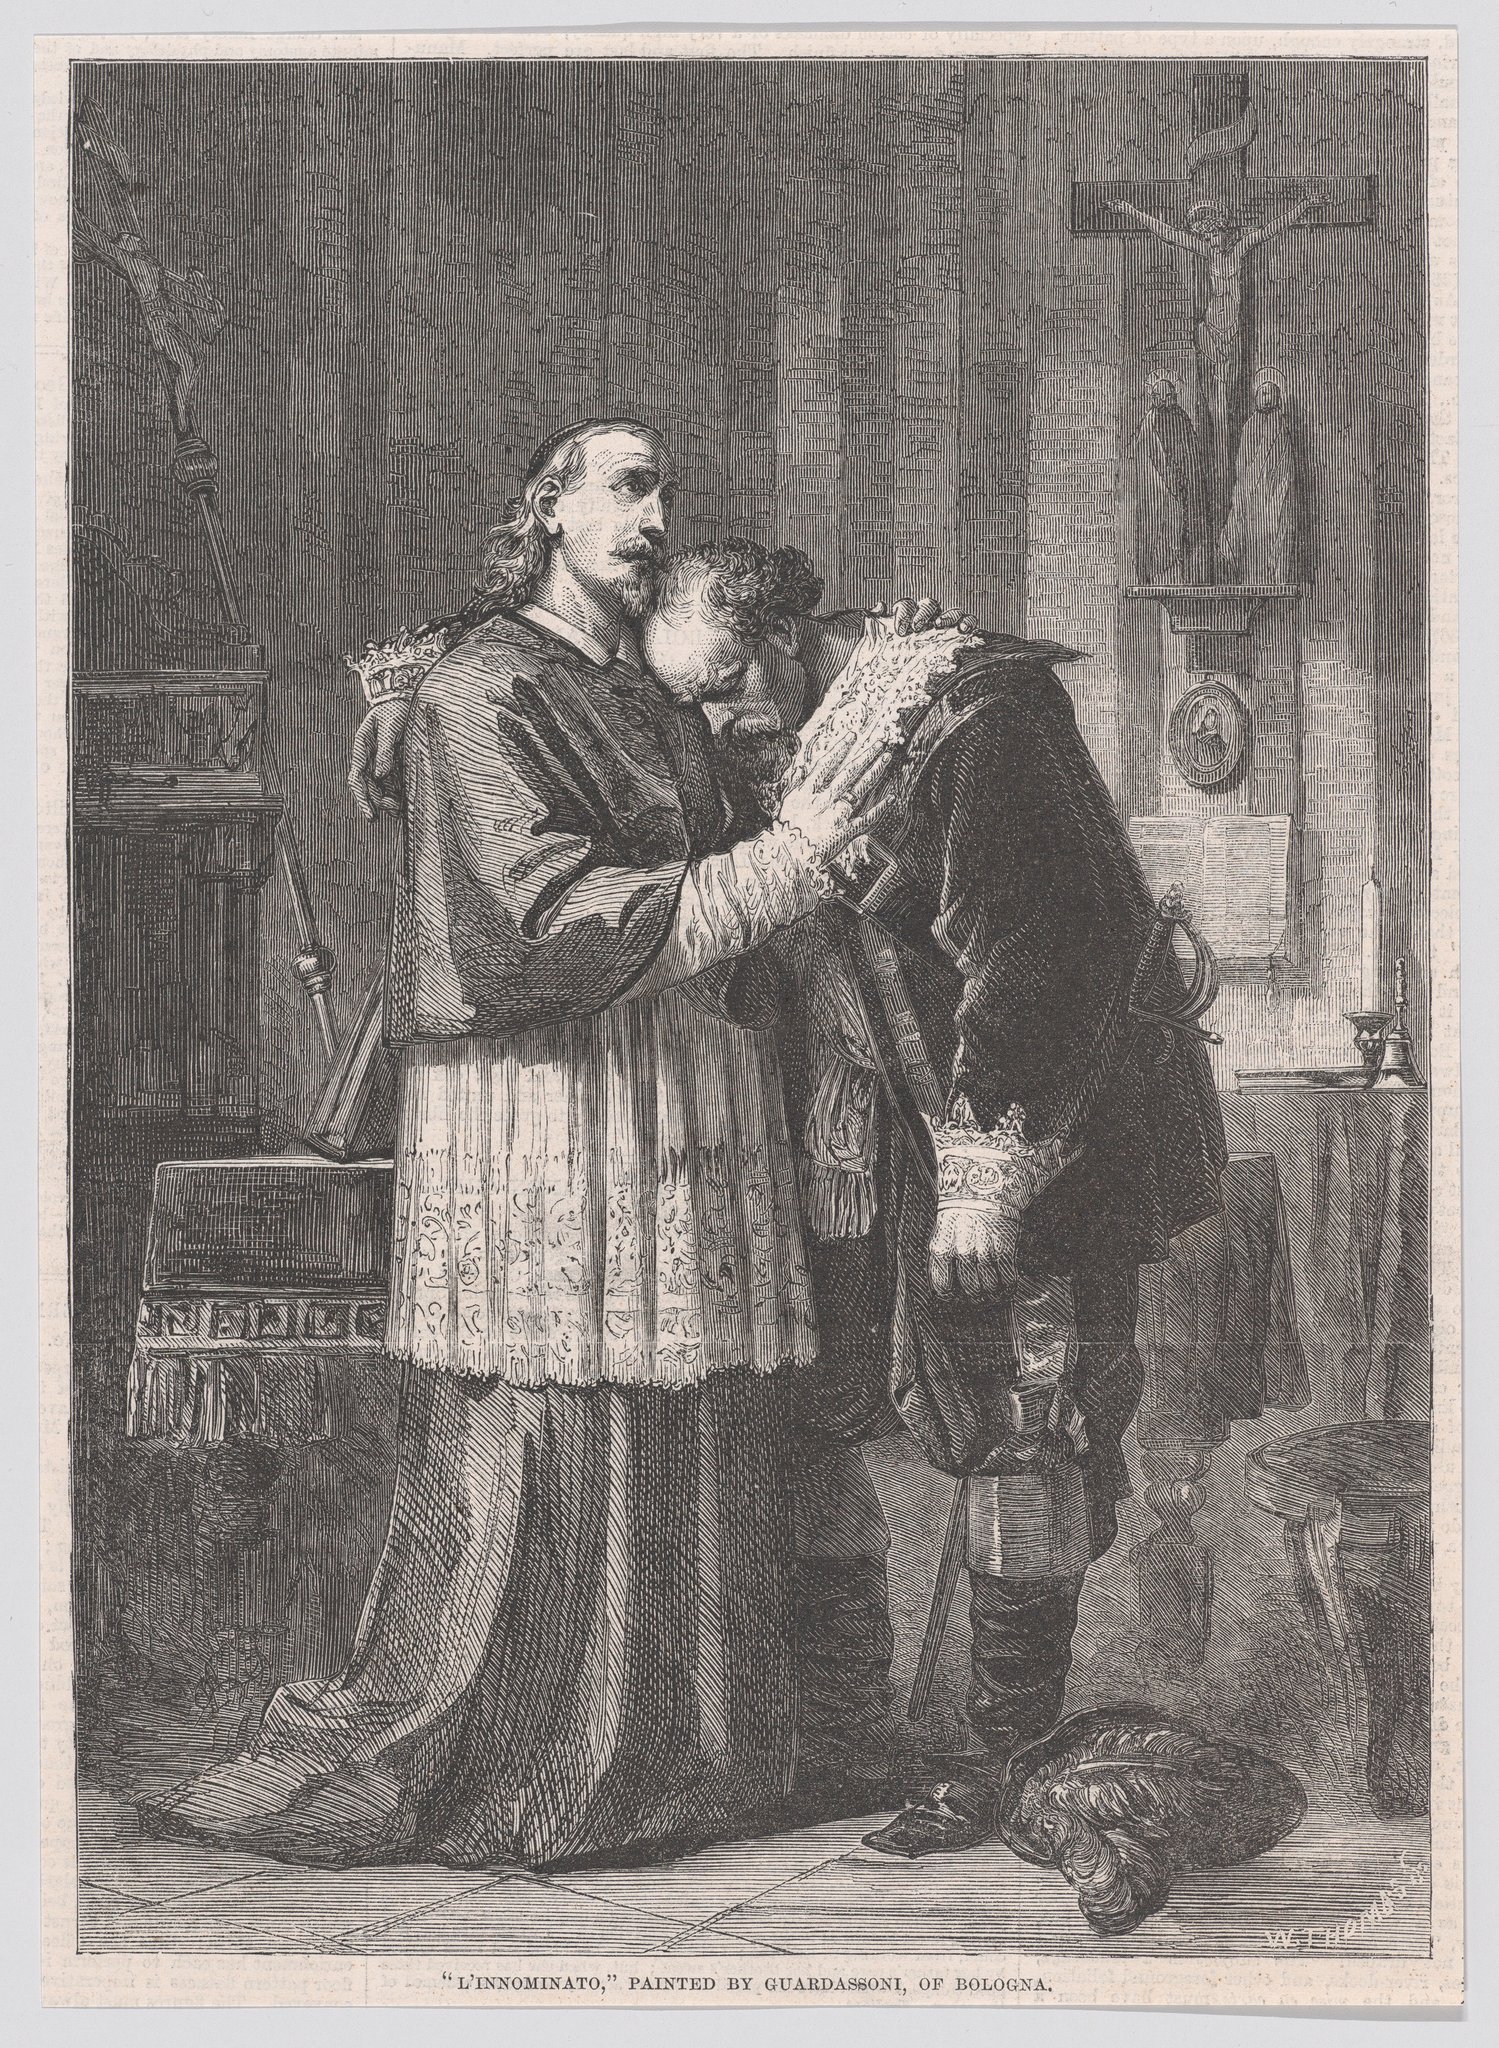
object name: print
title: L'Innominato, from "Illustrated London News"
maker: william luson thomas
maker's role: engraver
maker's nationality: british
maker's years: 1830-1900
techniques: engraving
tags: men